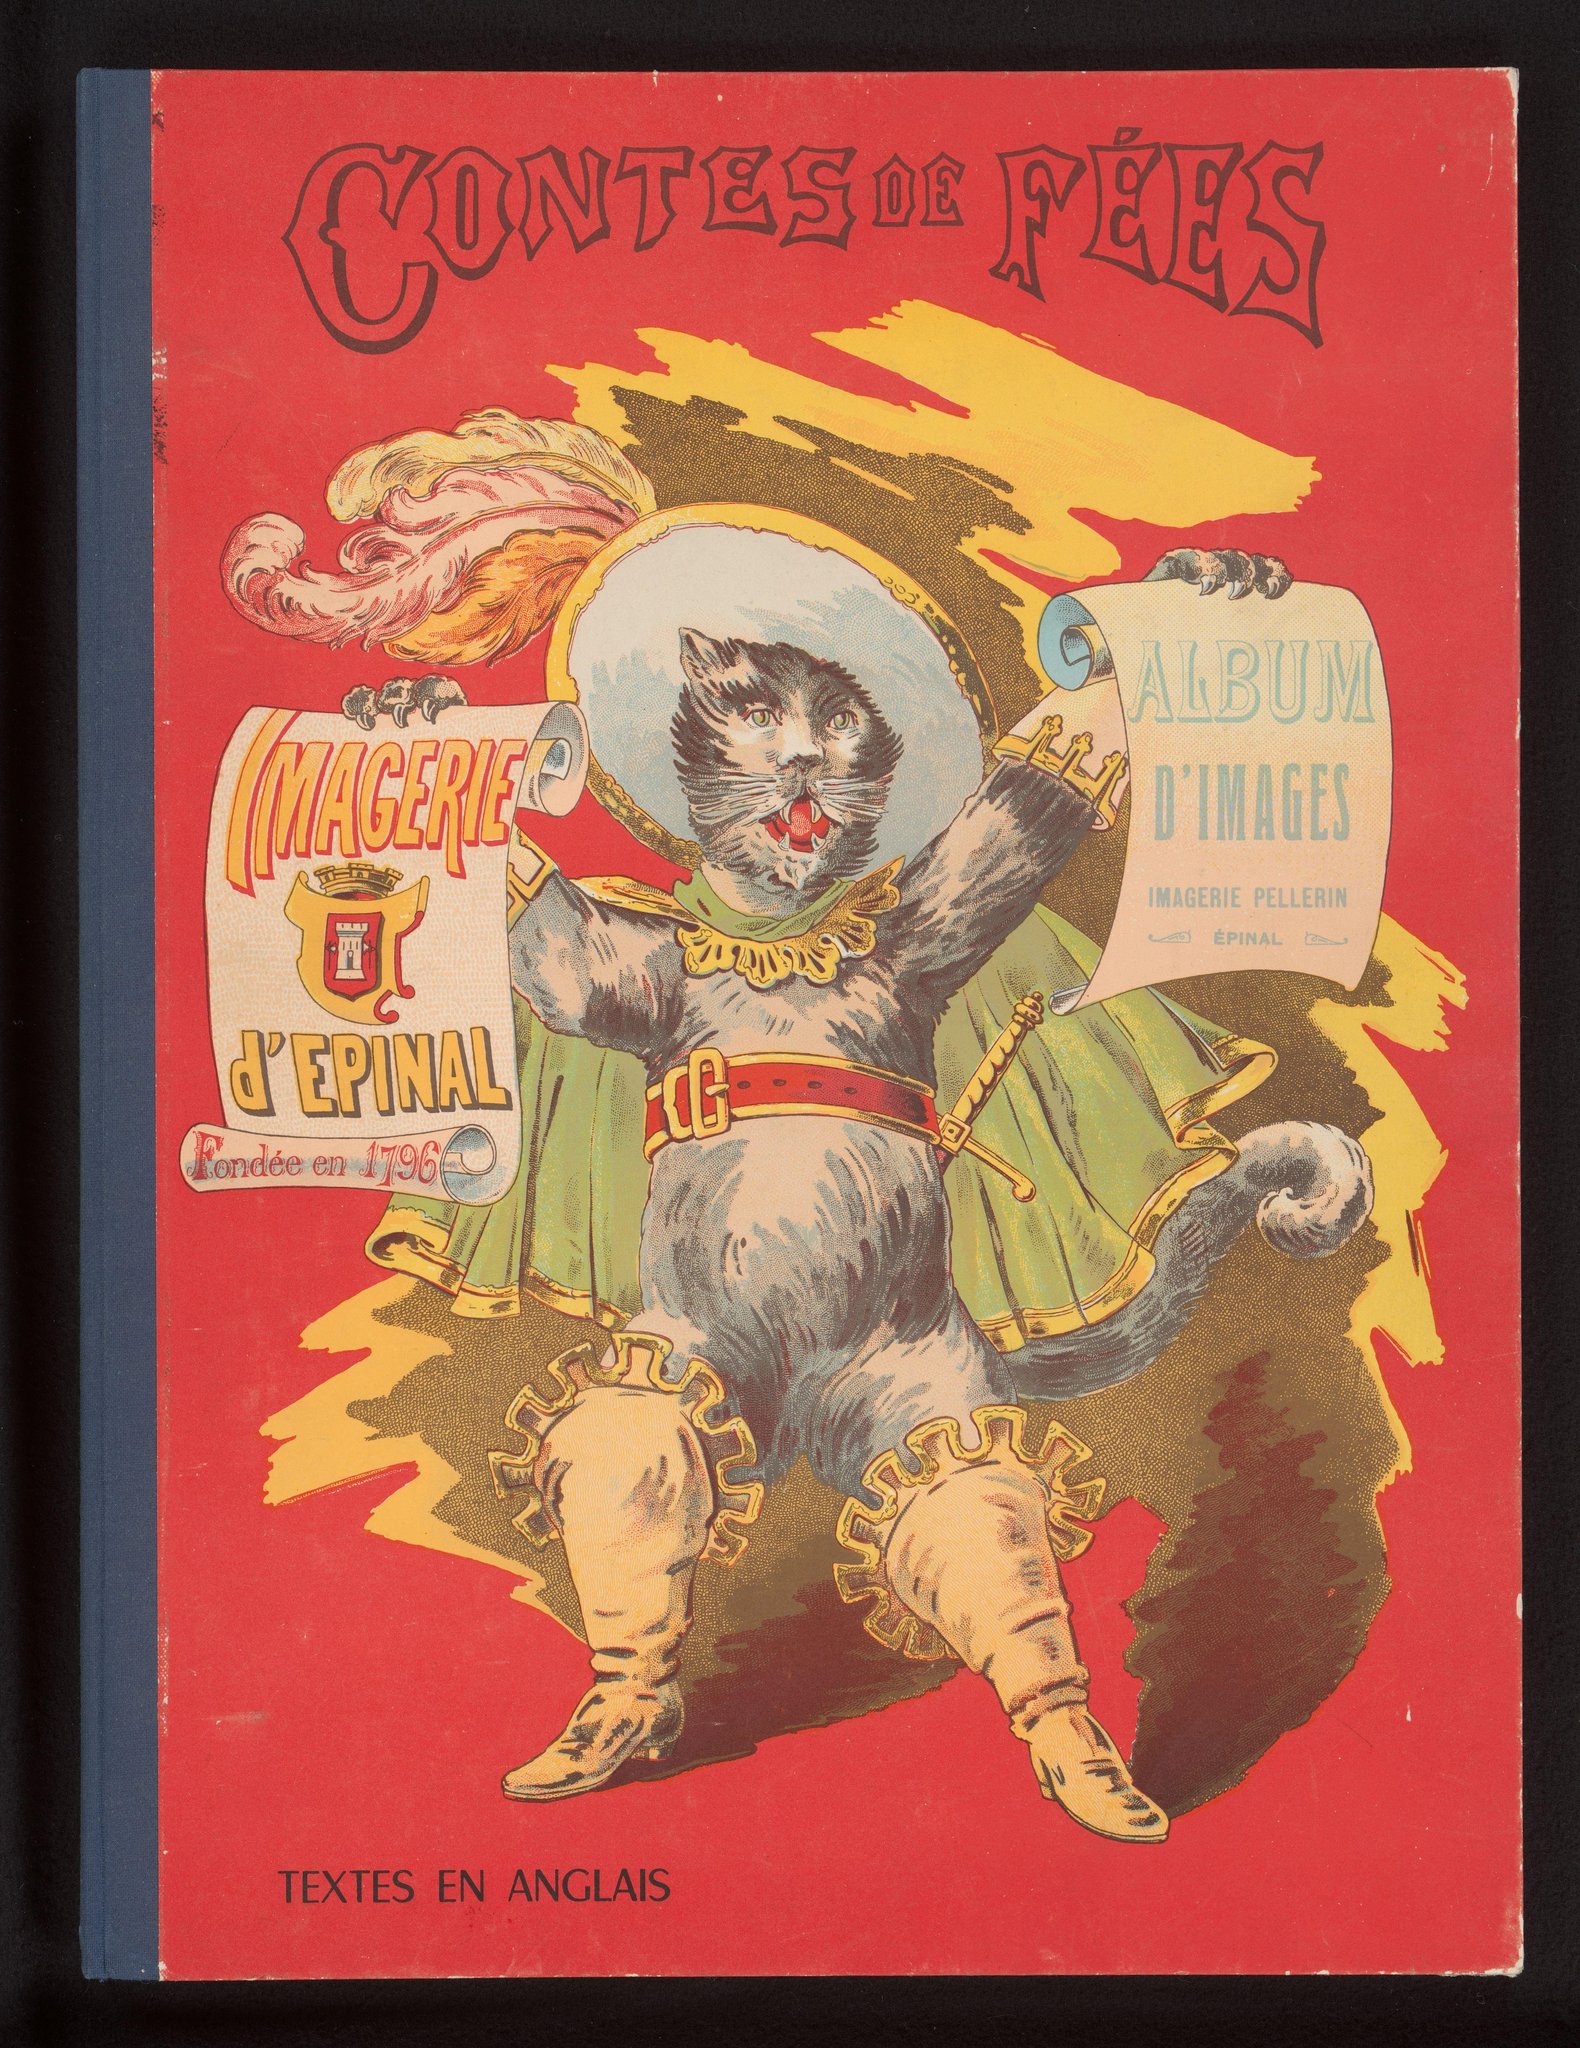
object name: prentrecueil, prentenalbum, prentalbum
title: Contes de Fées / Album d'images / Imagerie Pellerin / Épinal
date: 1893-1894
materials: cardboard, linen, paper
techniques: bookbinding, lithograph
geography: epinal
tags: tales and fairy tales: puss in boots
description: Lege albumomslag voor een album met 60 prenten uit het fonds van Pellerin (Épinal), uitgegeven met Engelse teksten. Op de omslag een afbeelding van de Gelaarsde kat.